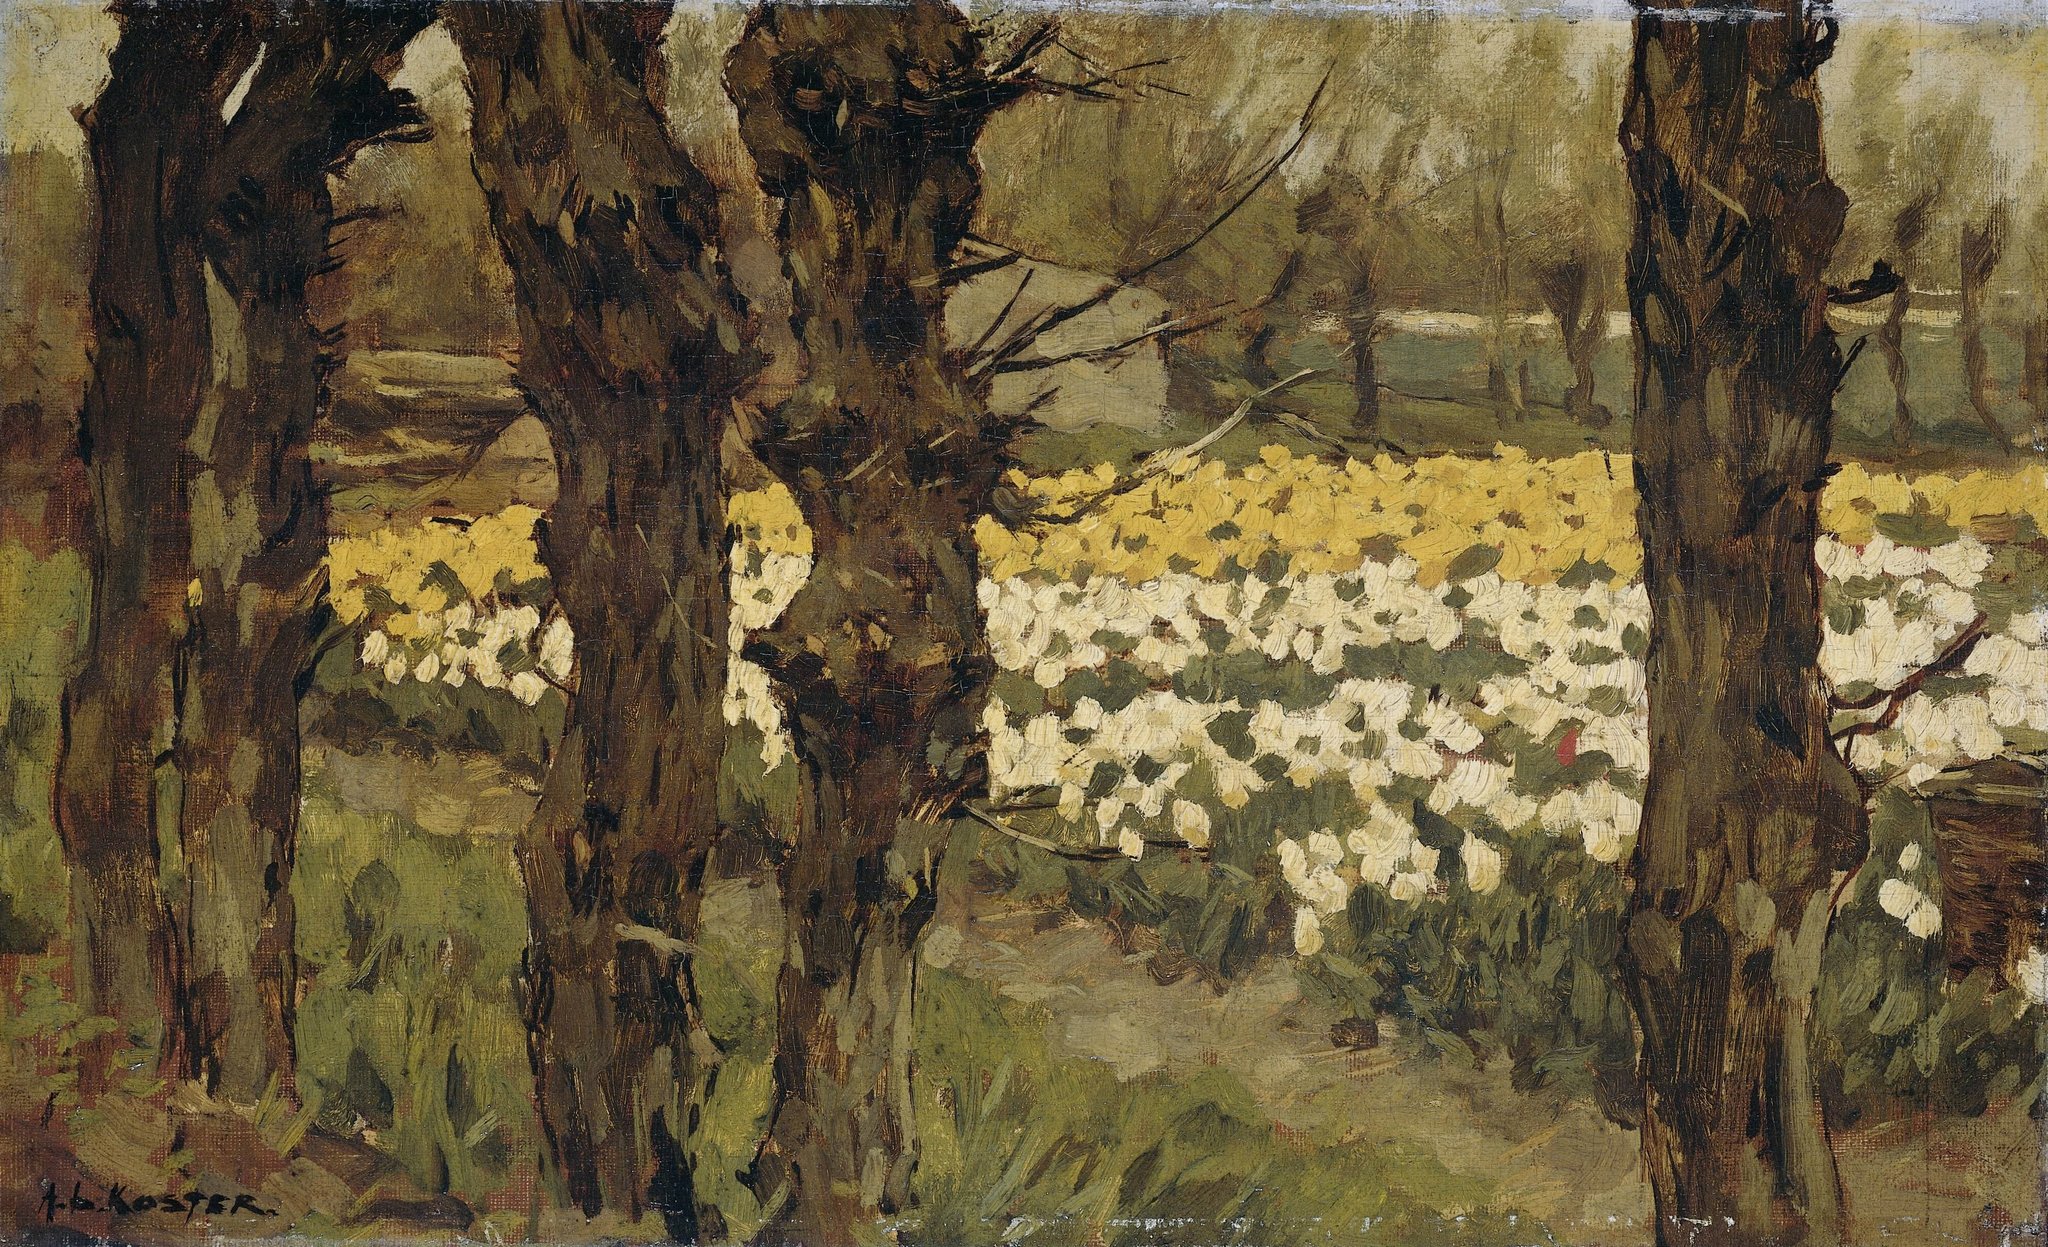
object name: painting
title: Tulip Fields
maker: anton l. koster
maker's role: draughtsman, painter, print maker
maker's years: 1859-1937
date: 1880-1937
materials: canvas, cardboard, oil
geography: netherlands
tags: bulb field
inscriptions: signature: ‘A.L. Koster’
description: Bollenvelden. Veld met bloeiende gele en witte tulpen omzoomd door bomen.